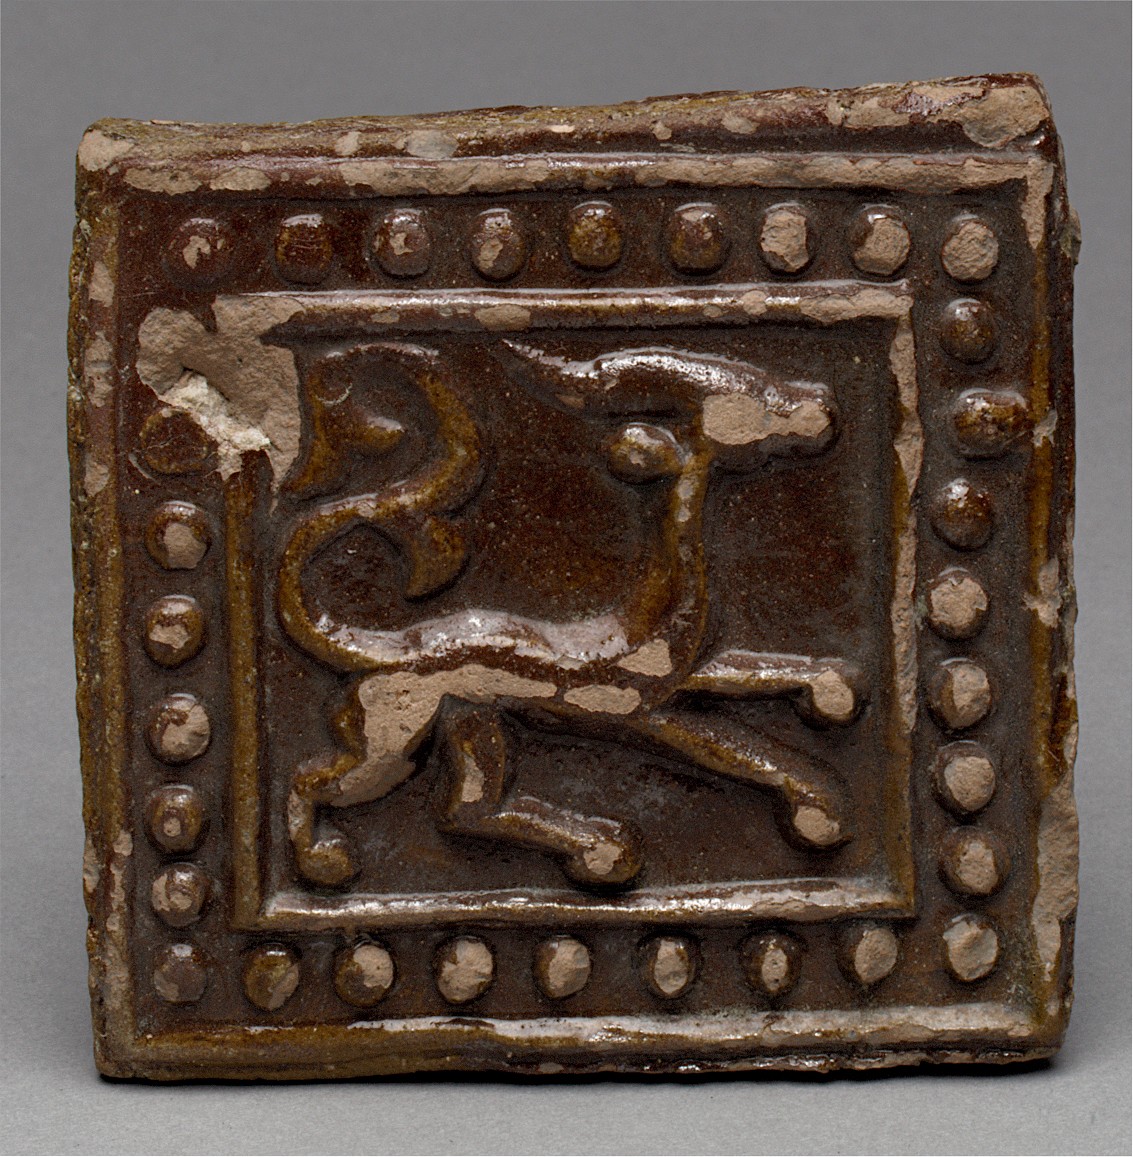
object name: tile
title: Square Tile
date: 1167-1233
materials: earthenware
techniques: glazing, molding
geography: afghanistan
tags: animals